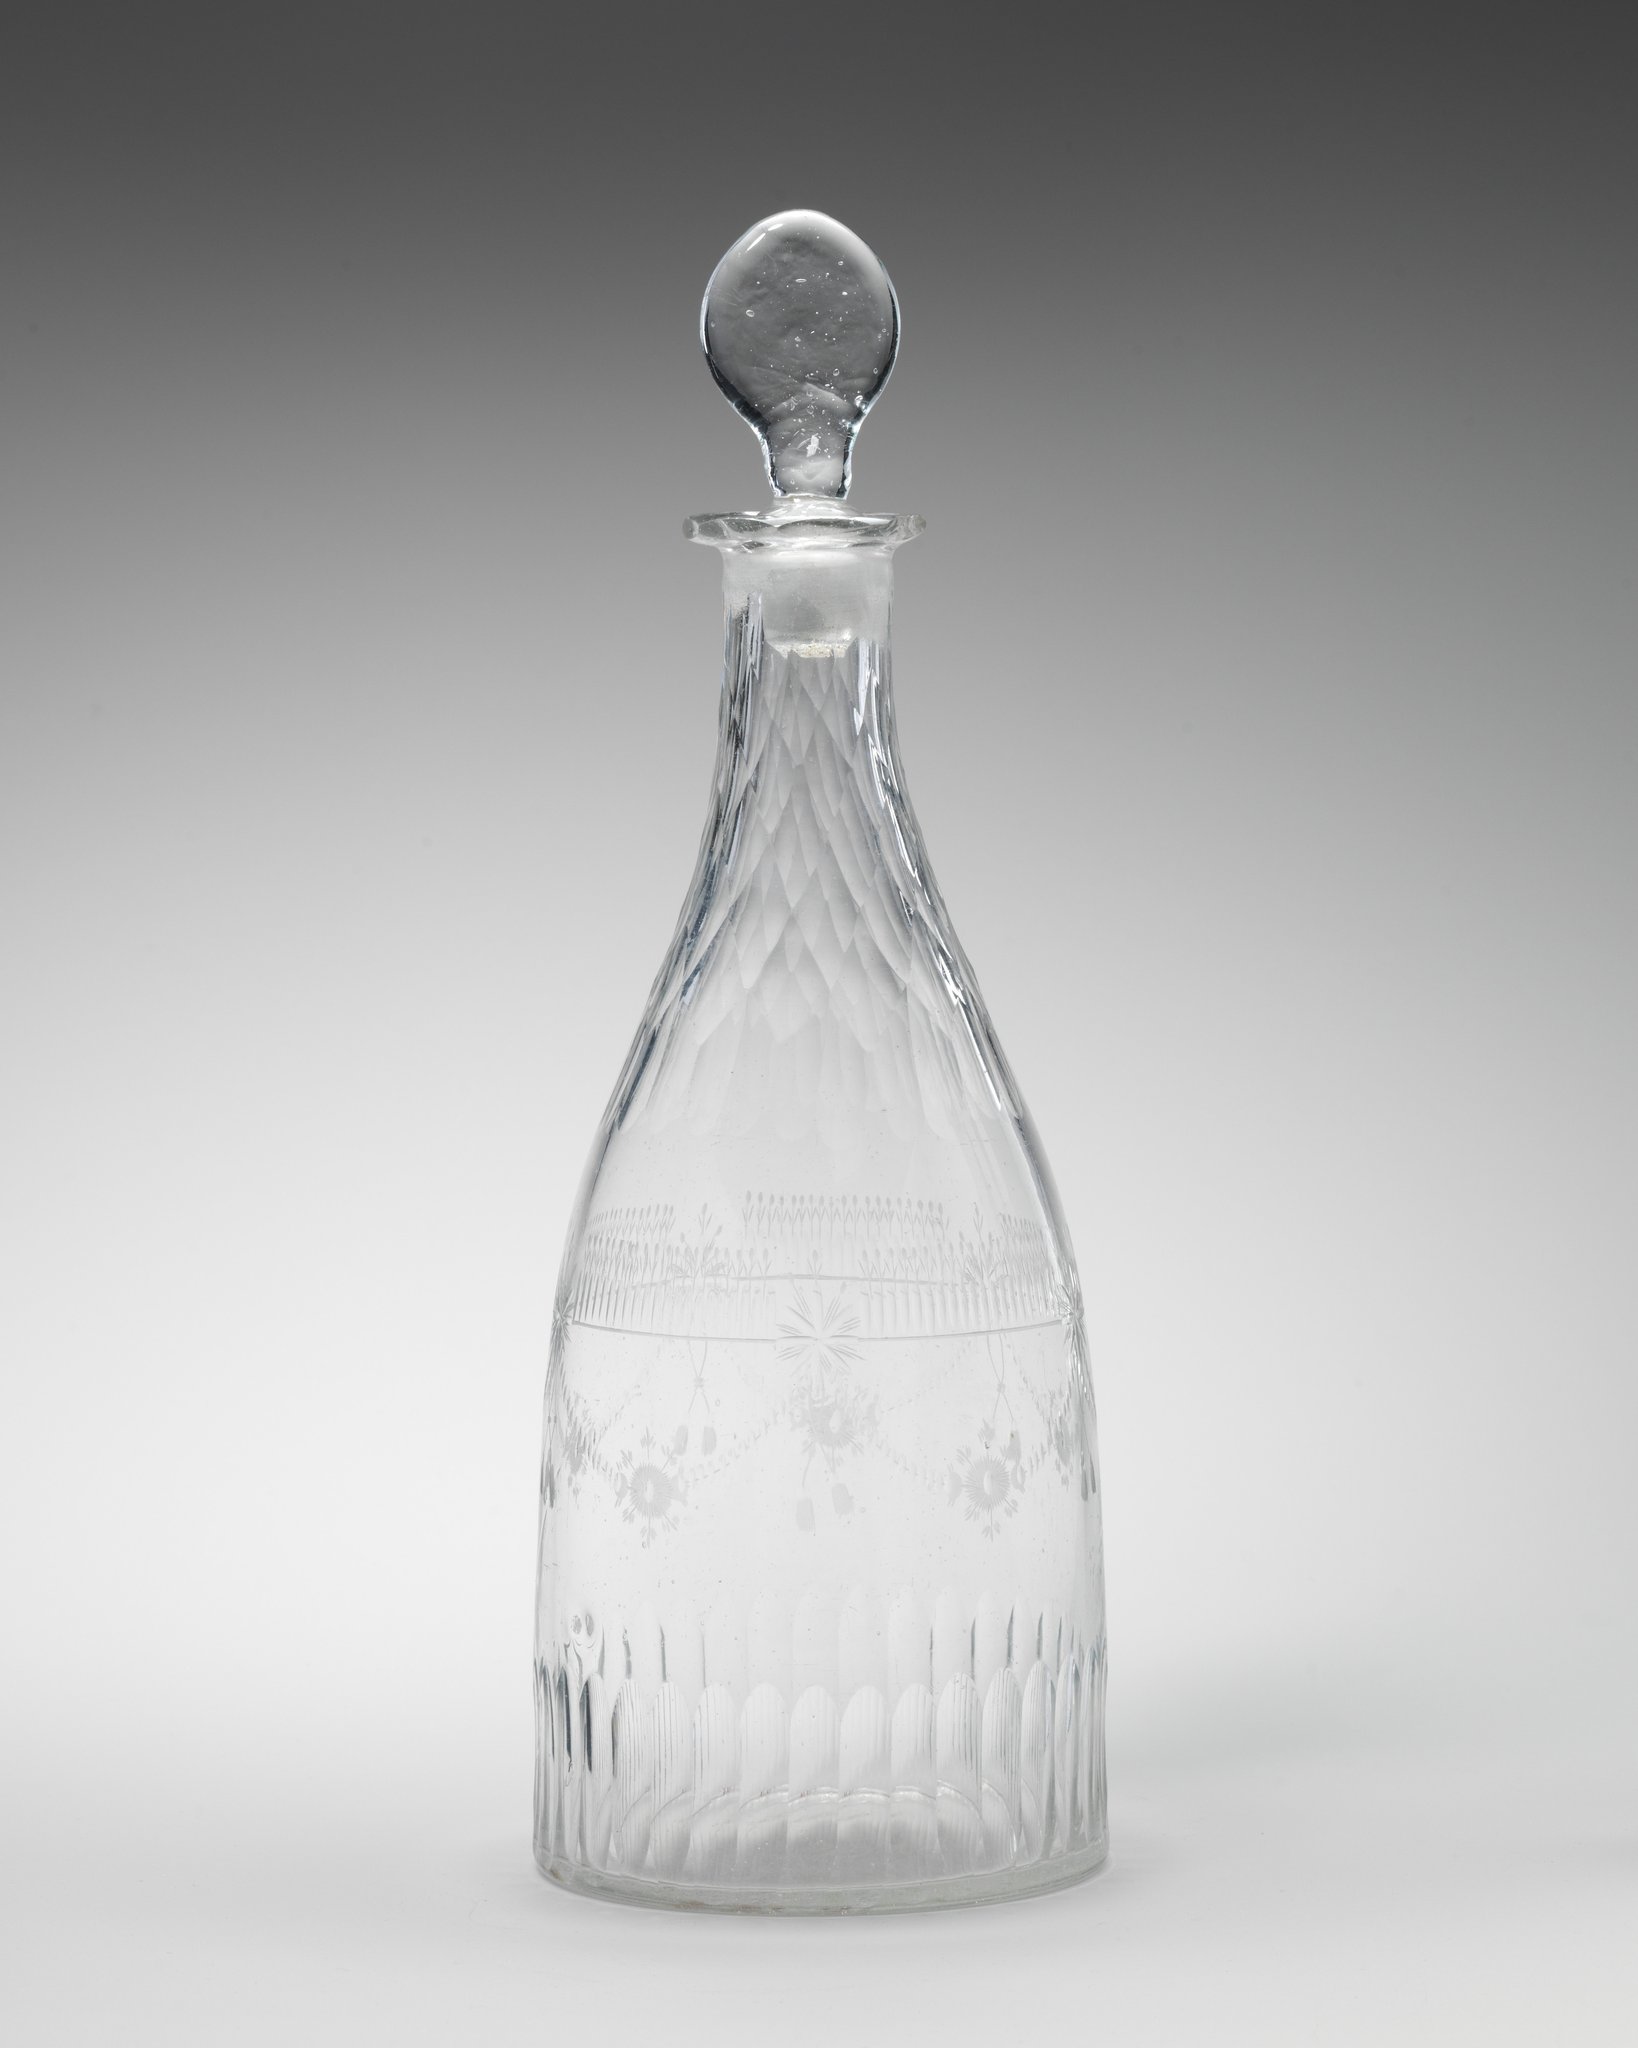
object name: decanter with stopper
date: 1767-1800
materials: glass